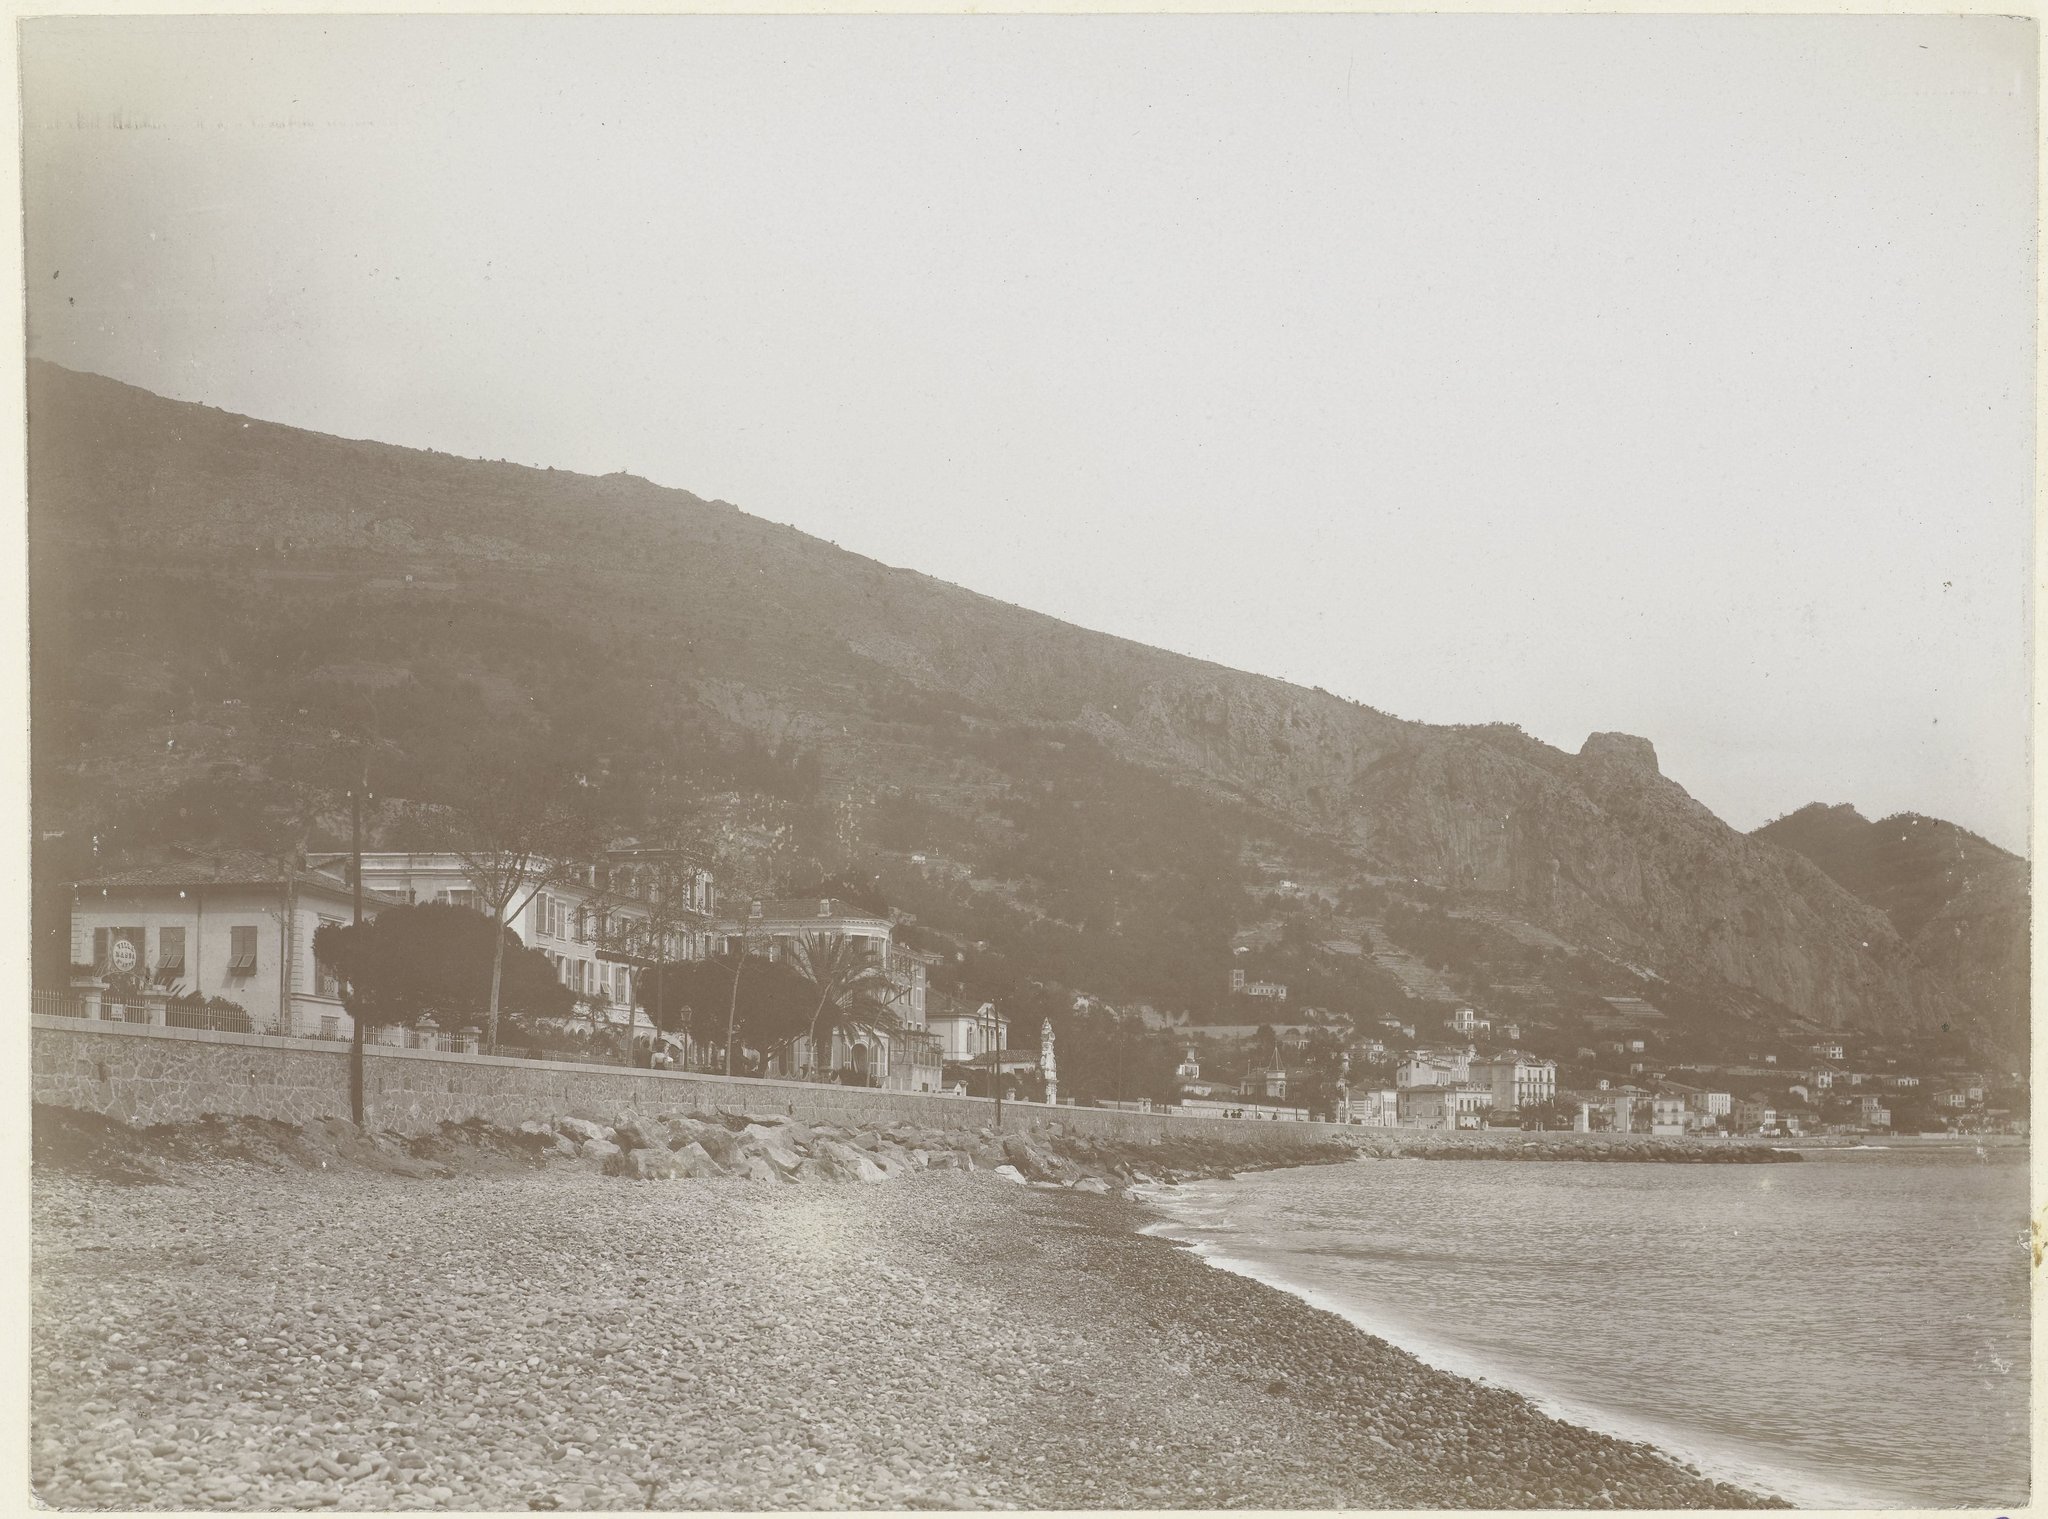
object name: photograph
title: Menton gezien vanaf het strand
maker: henry pauw van wieldrecht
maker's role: fotograaf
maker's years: 1863-1912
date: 1886-1896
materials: cardboard, photographic support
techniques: albumen print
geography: france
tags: menton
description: Menton gezien vanaf het strand. Op de voorgrond aan de linkerzijde bebouwing en aan de rechterzijde de zee. Op de achtergrond een berglandschap